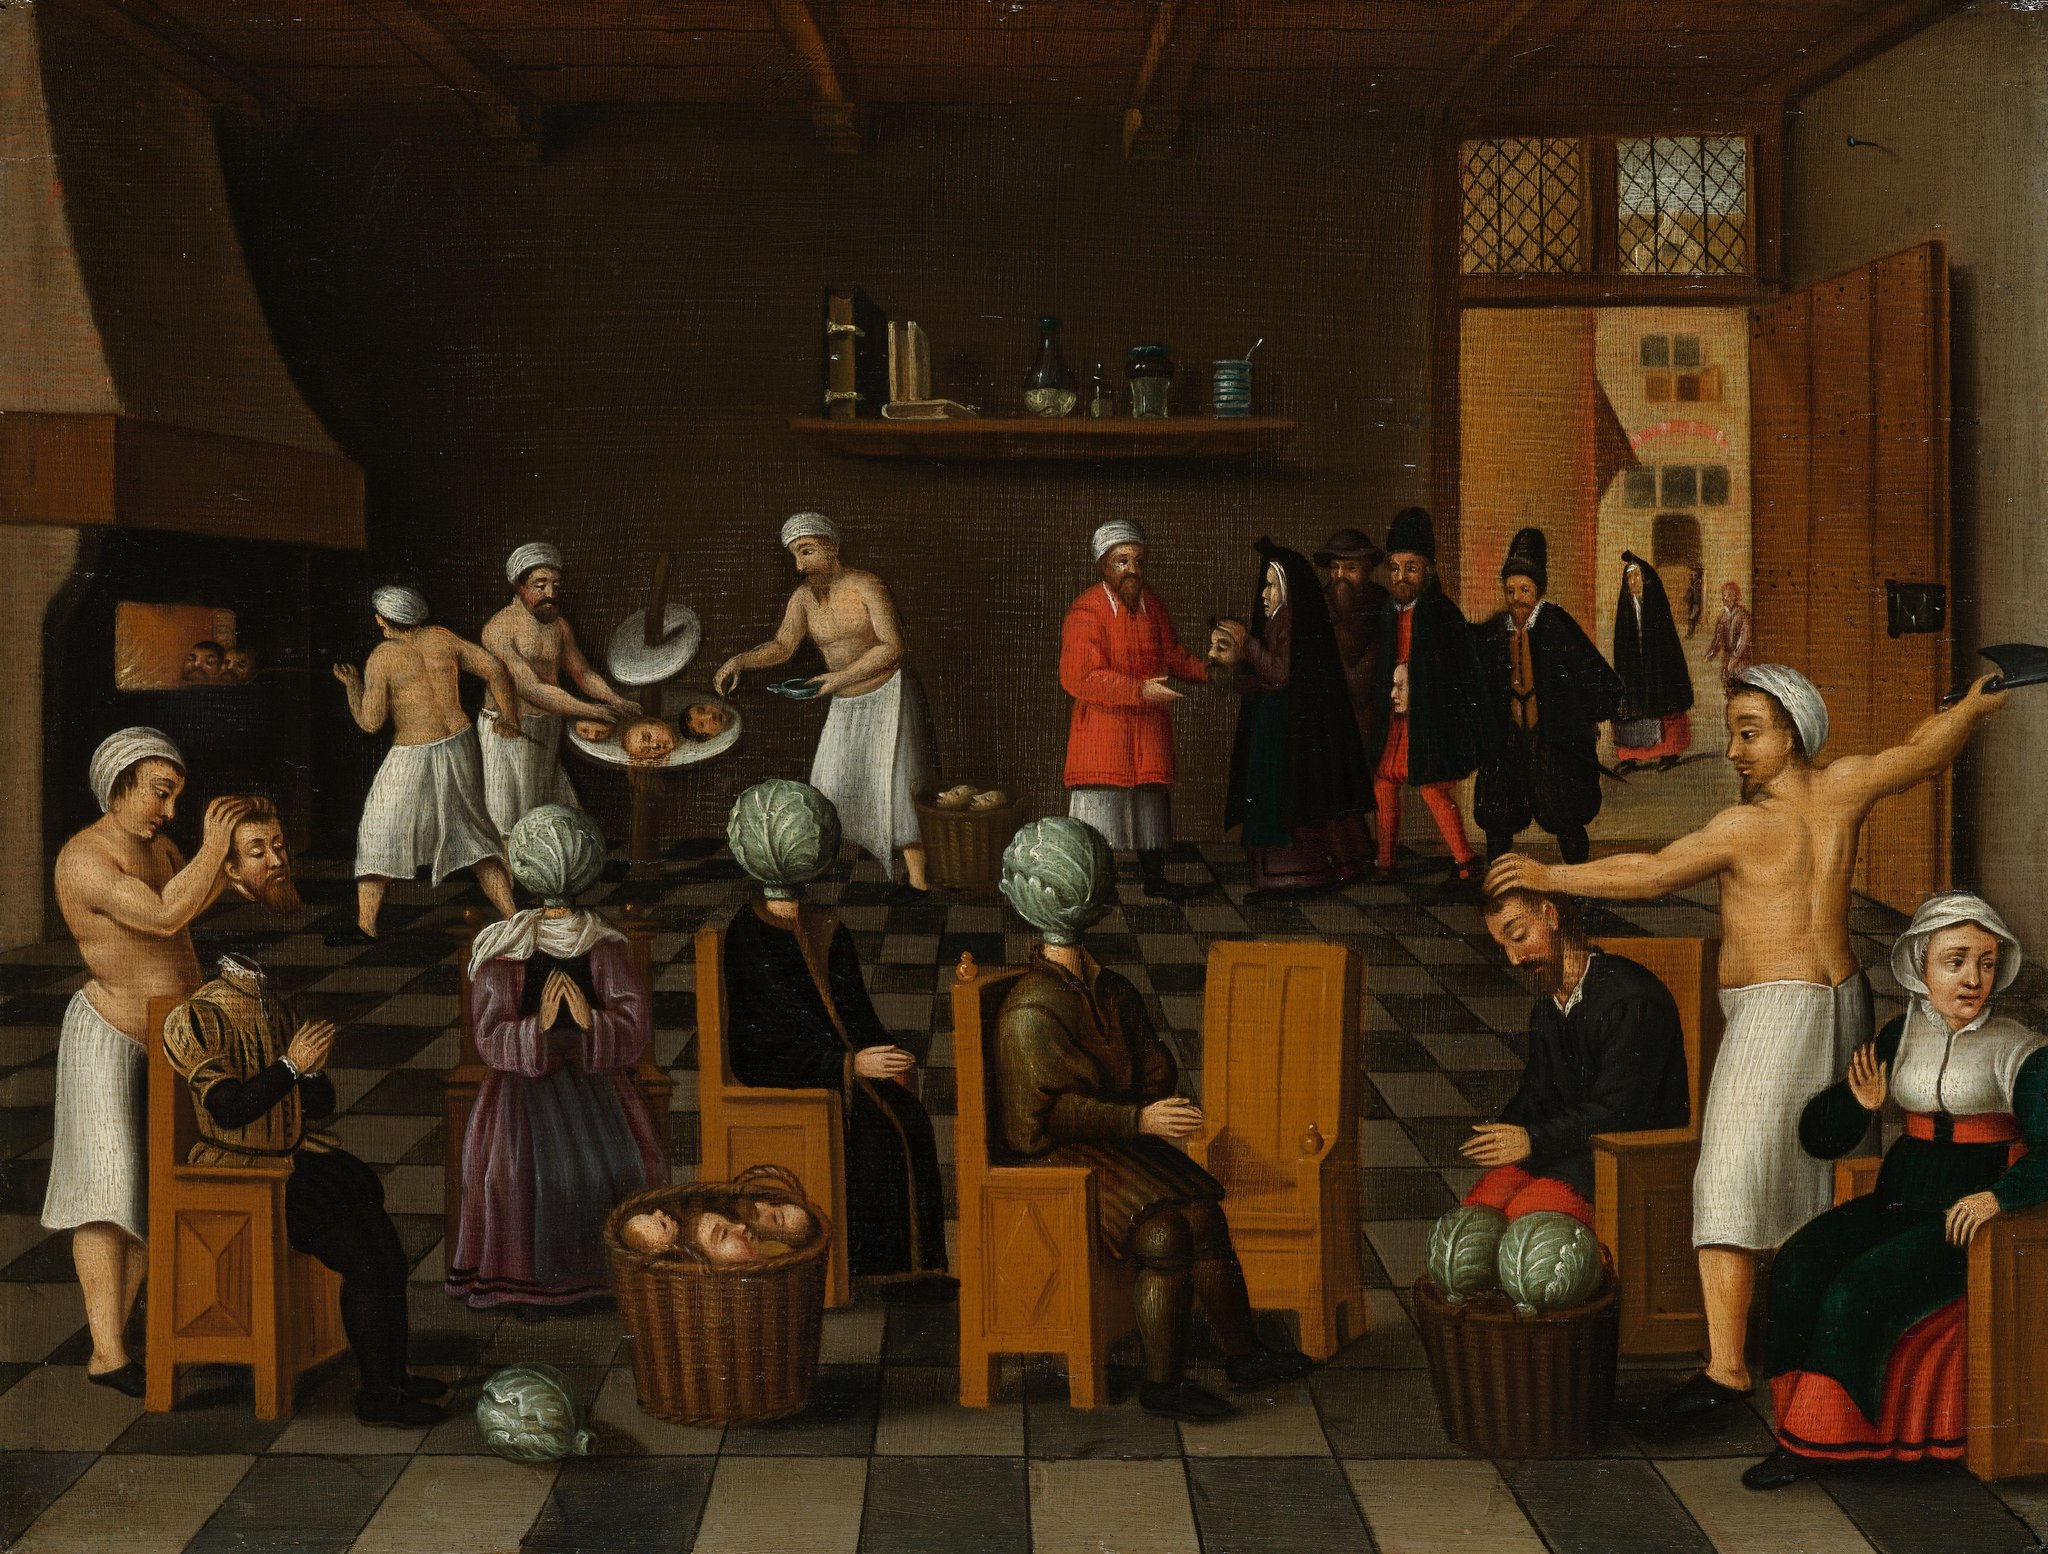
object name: painting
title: The Legend of the Baker of Eekloo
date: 1550-1650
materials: oil, panel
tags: baking the head, e.g. by the baker of eeclo (heads temporarily replaced by cabbages)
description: De legende van de bakker van Eekloo. Interieur van een keuken waar mensen hun hoofden in een oven laten ombakken, in de tussentijd wordt zolang een groene kool op de hals gezet.